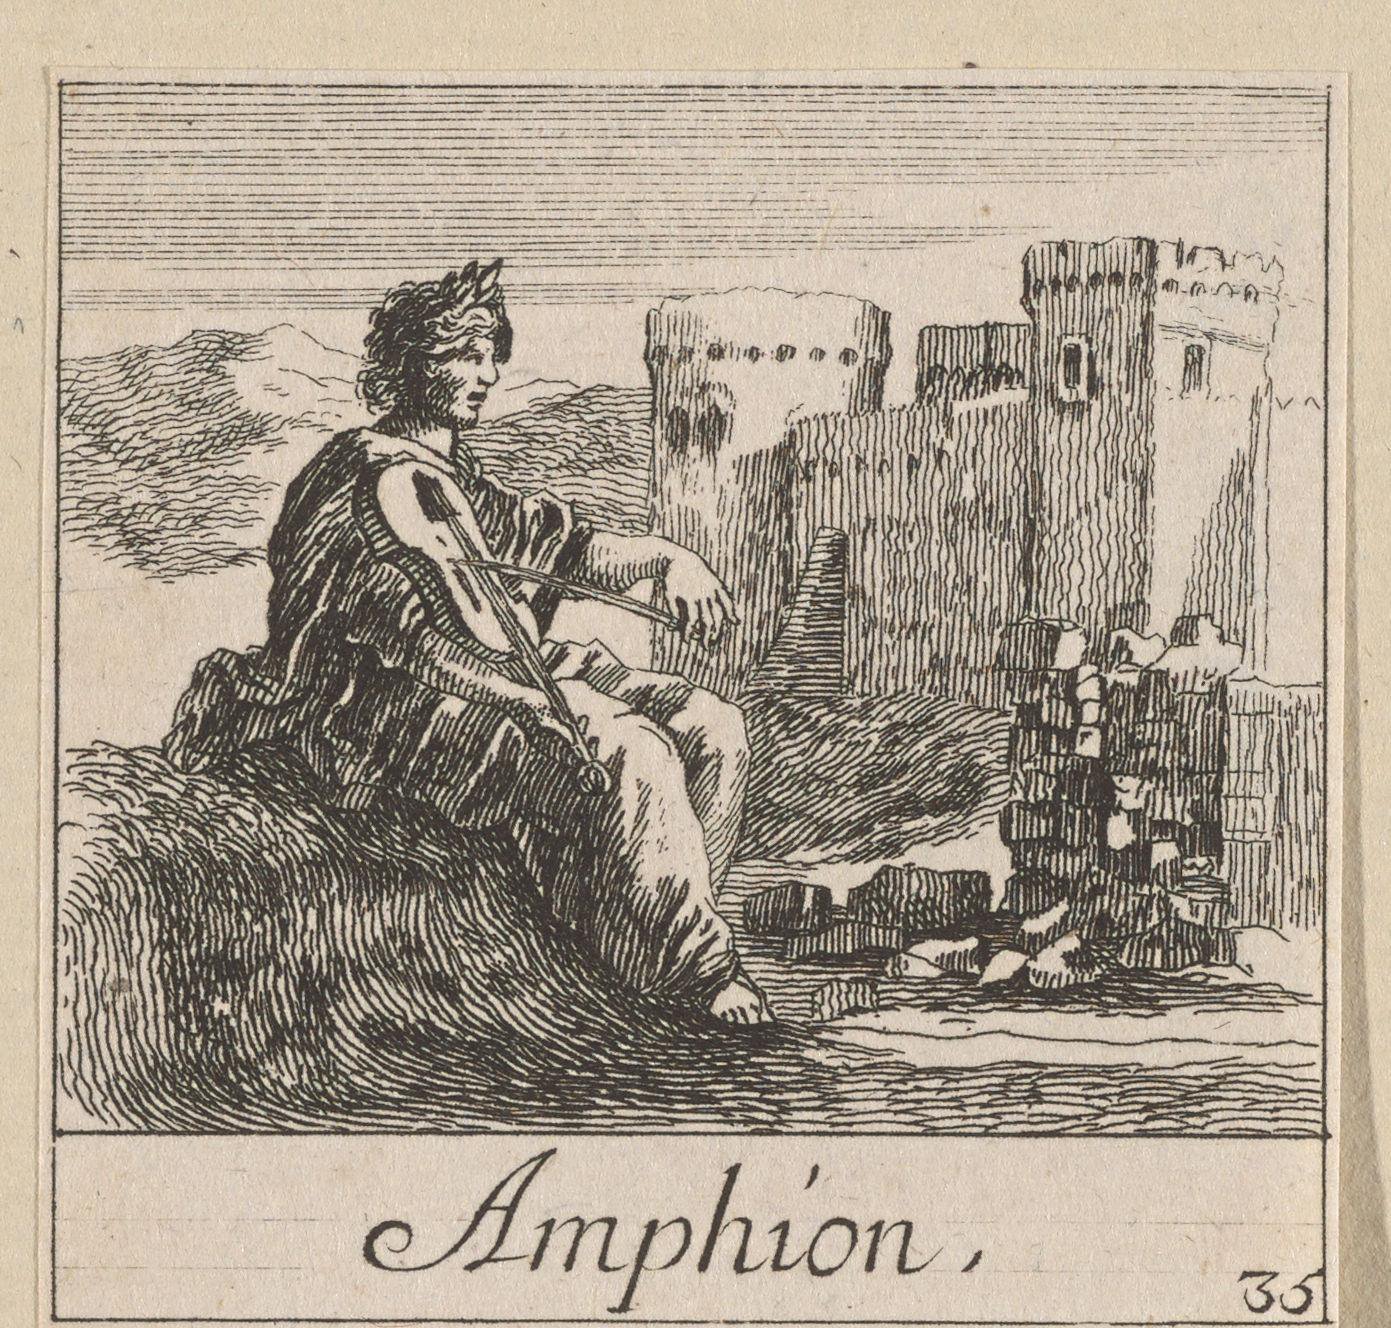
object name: print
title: Jeu des fables (kopie)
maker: Anonymous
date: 1620-1664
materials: paper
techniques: etching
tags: (story of) amphion and zethus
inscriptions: collector's mark: Lugt 240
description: Prent uit een reeks van 54 genummerde speelkaarten met voorstellingen uit de Metamorfosen van Ovidius.